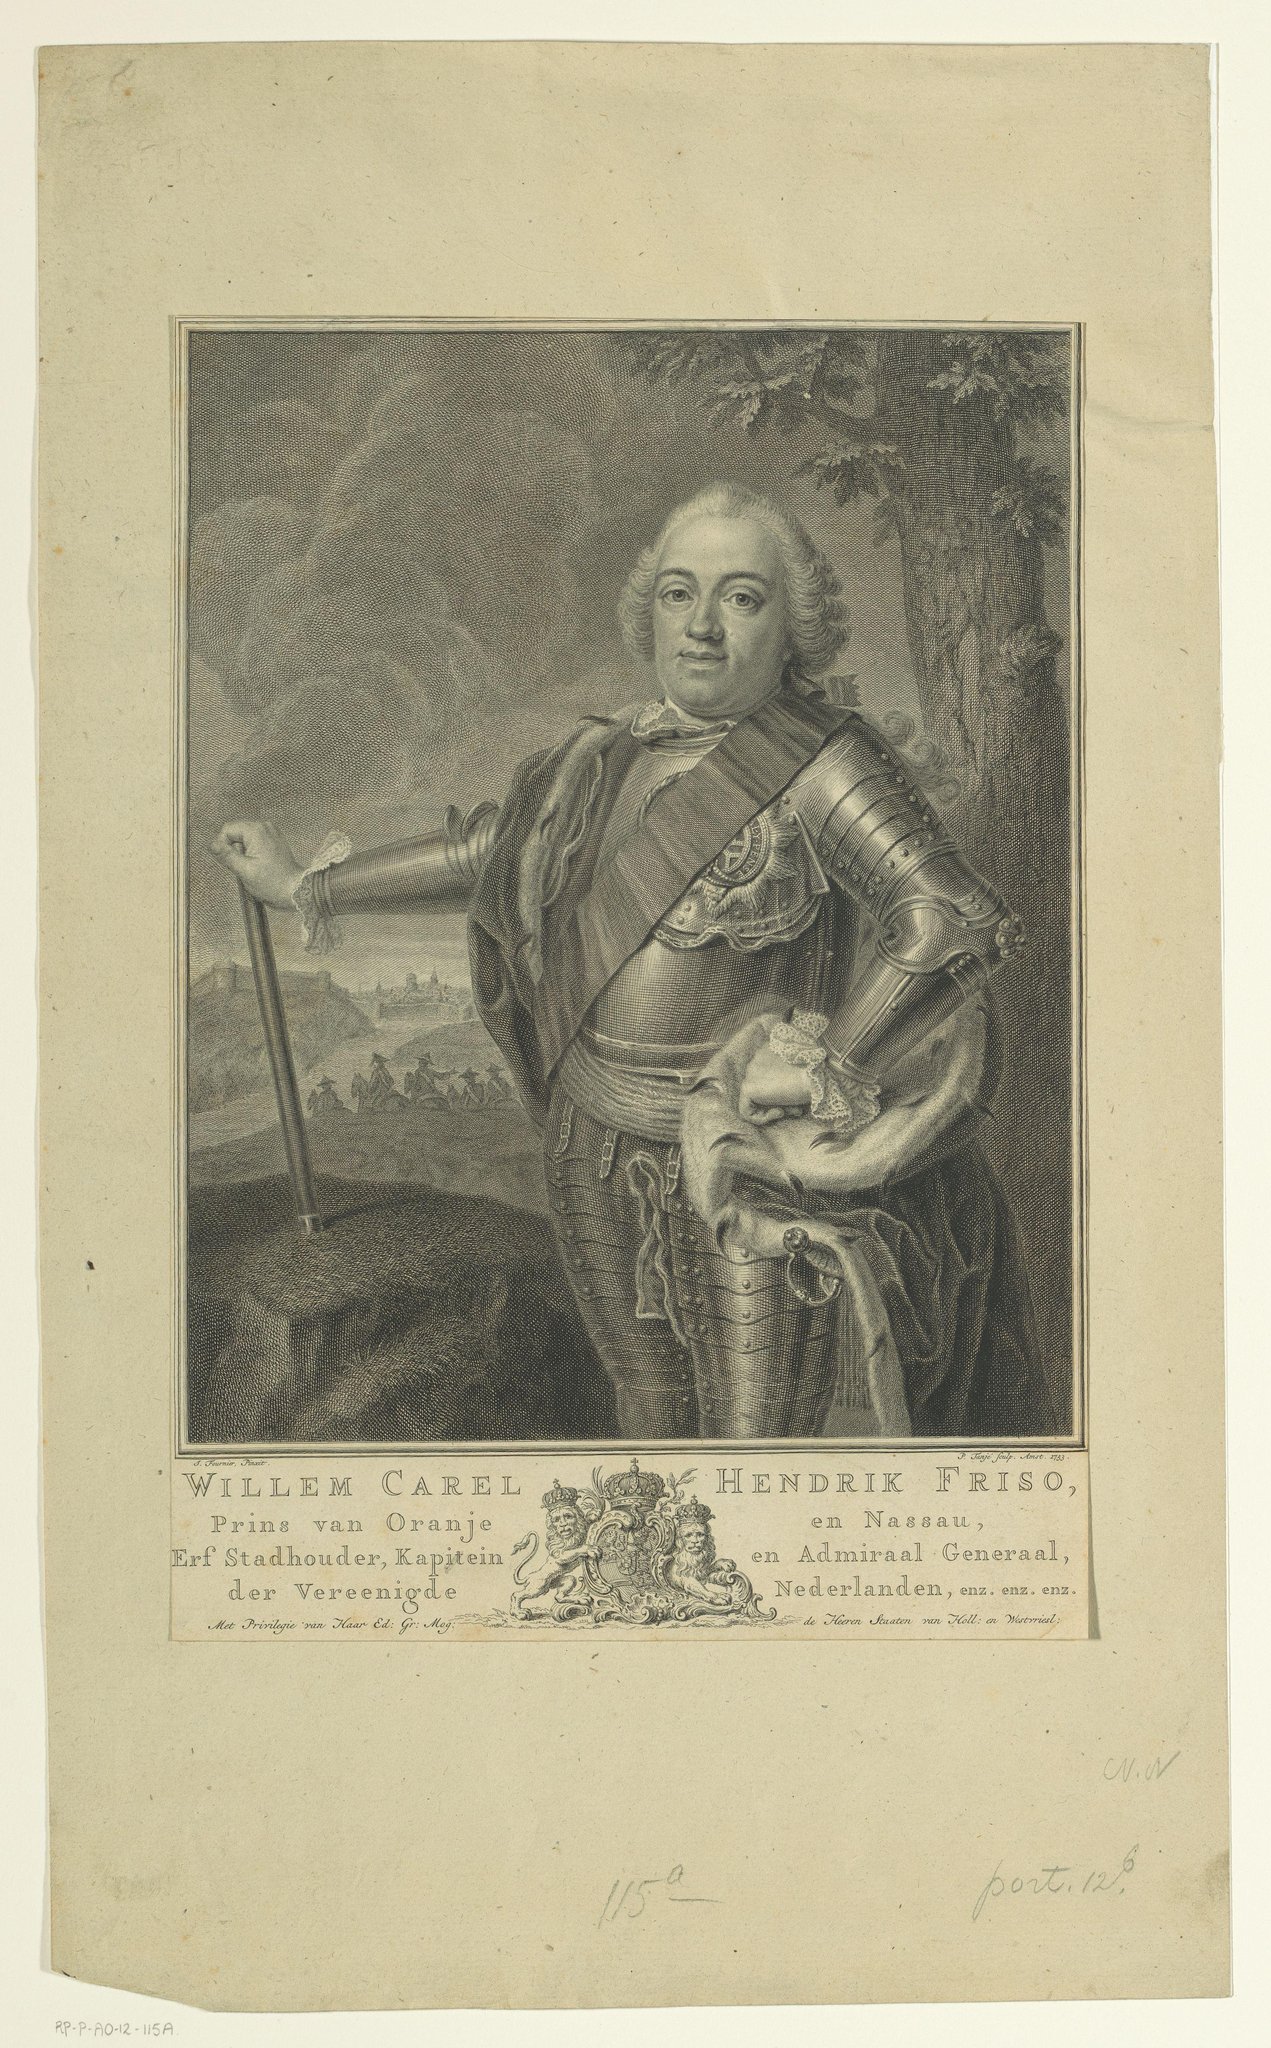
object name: print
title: Portret van prins Willem IV van Oranje-Nassau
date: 1753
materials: paper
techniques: engraving, etching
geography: amsterdam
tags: the hague, willem iv (prins van oranje-nassau), knighthood order (garter) - insignia of a knighthood order, e.g.: badge, chain, commander-in-chief, general, marshal, historical persons, armorial bearing, heraldry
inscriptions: date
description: Willem IV, prins van Oranje-Nassau en stadhouder, staande, gekleed in harnas met veldheerstaf en hermelijnen mantel, in een landschap met op de achtergrond ruiters en een vestingstad. Onder het portret zijn naam en titels ter weerszijden van zijn wapen.